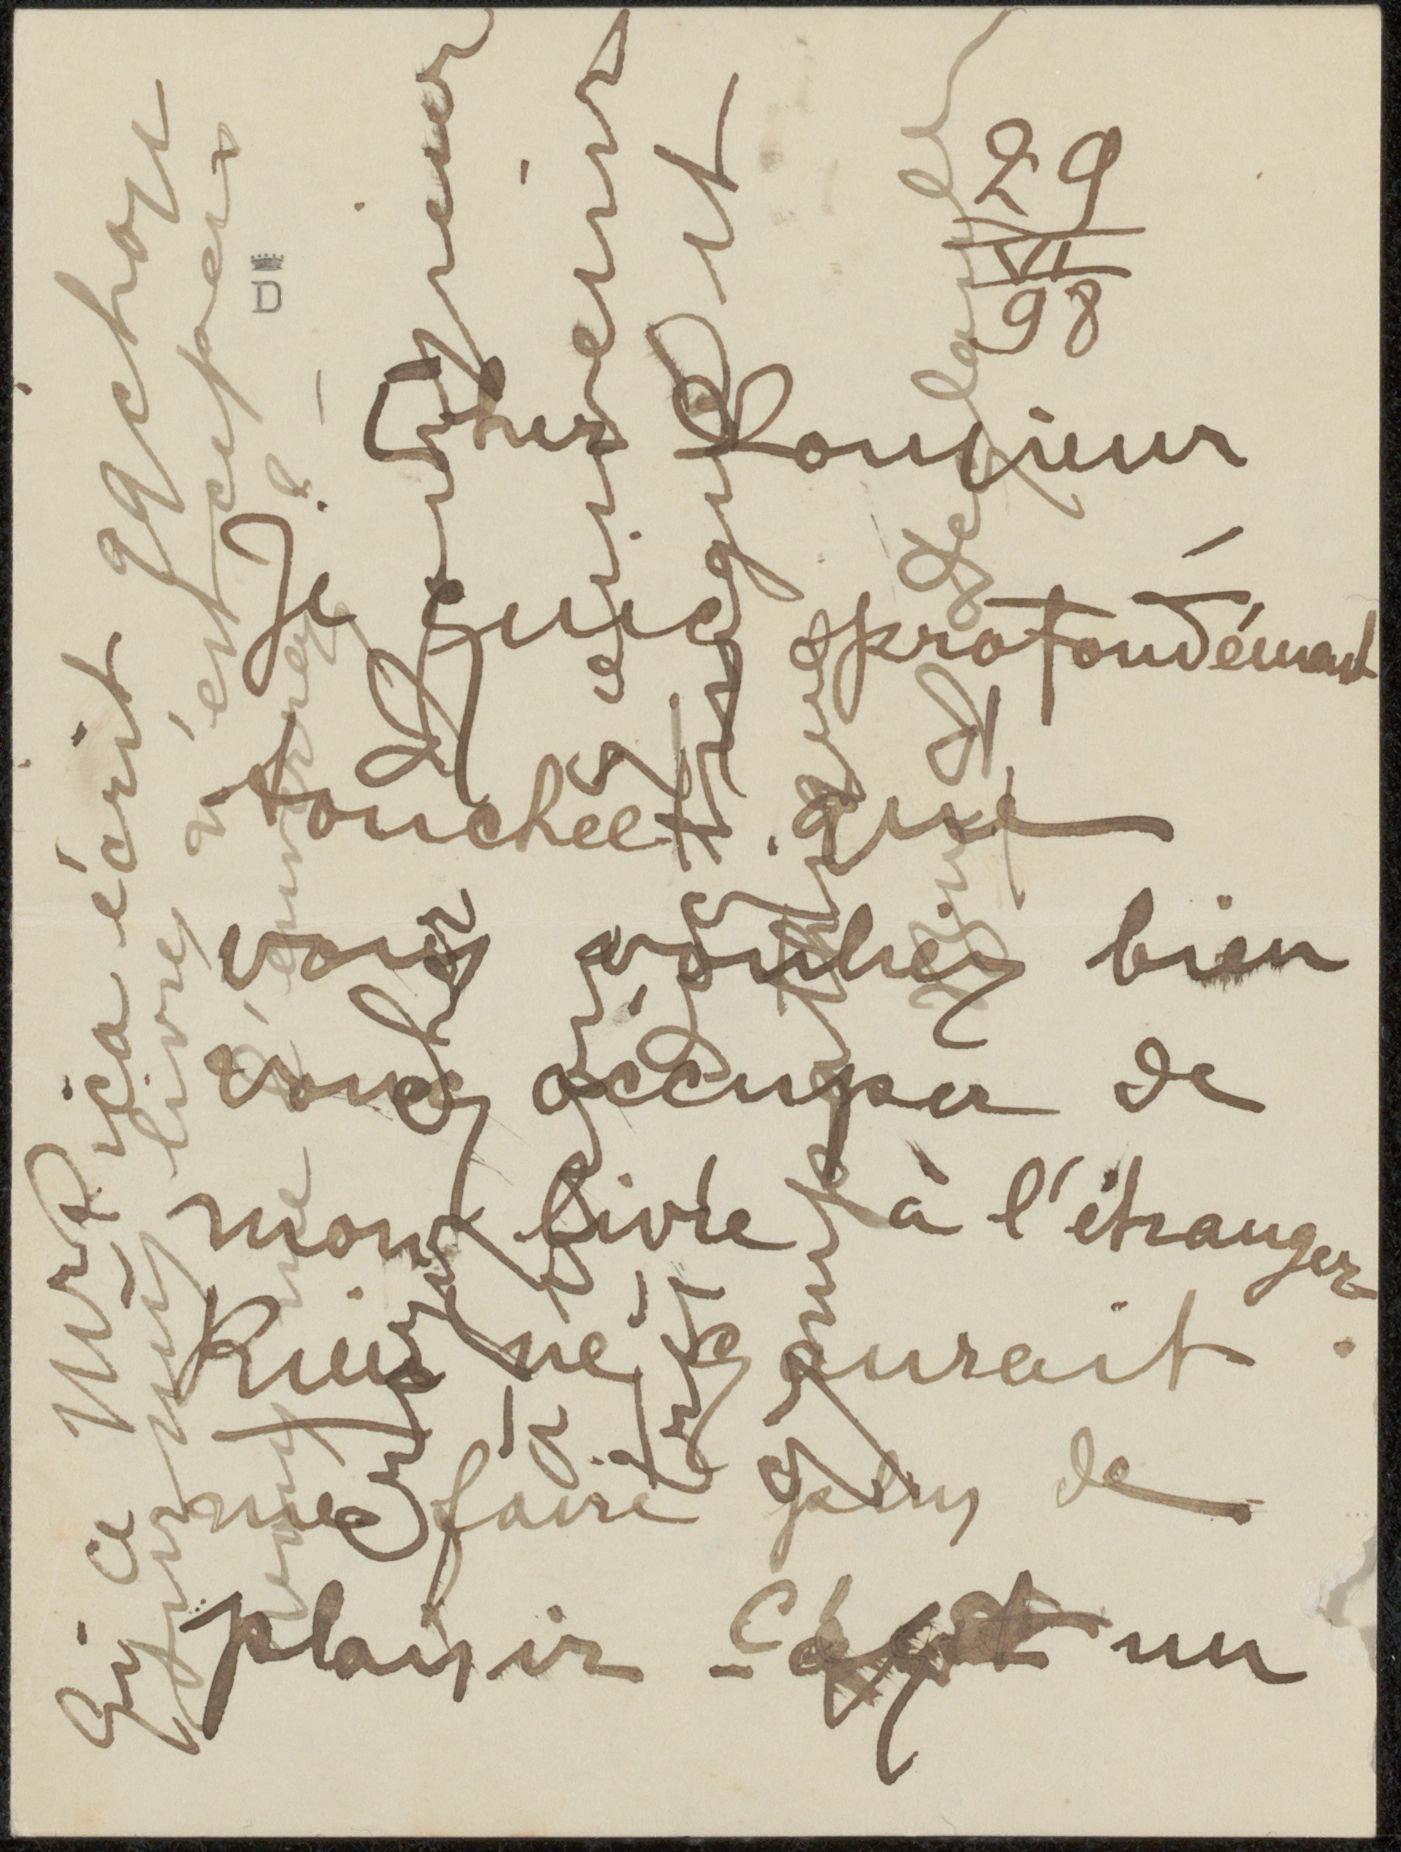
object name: letter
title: Brief aan Philip Zilcken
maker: baronne madeleine deslandes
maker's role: schrijver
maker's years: 1866-1929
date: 1898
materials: ink, paper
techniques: pen, writing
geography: paris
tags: the hague, painter, philip zilcken, literature ~ arts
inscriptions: collector's mark: ‘RPK’